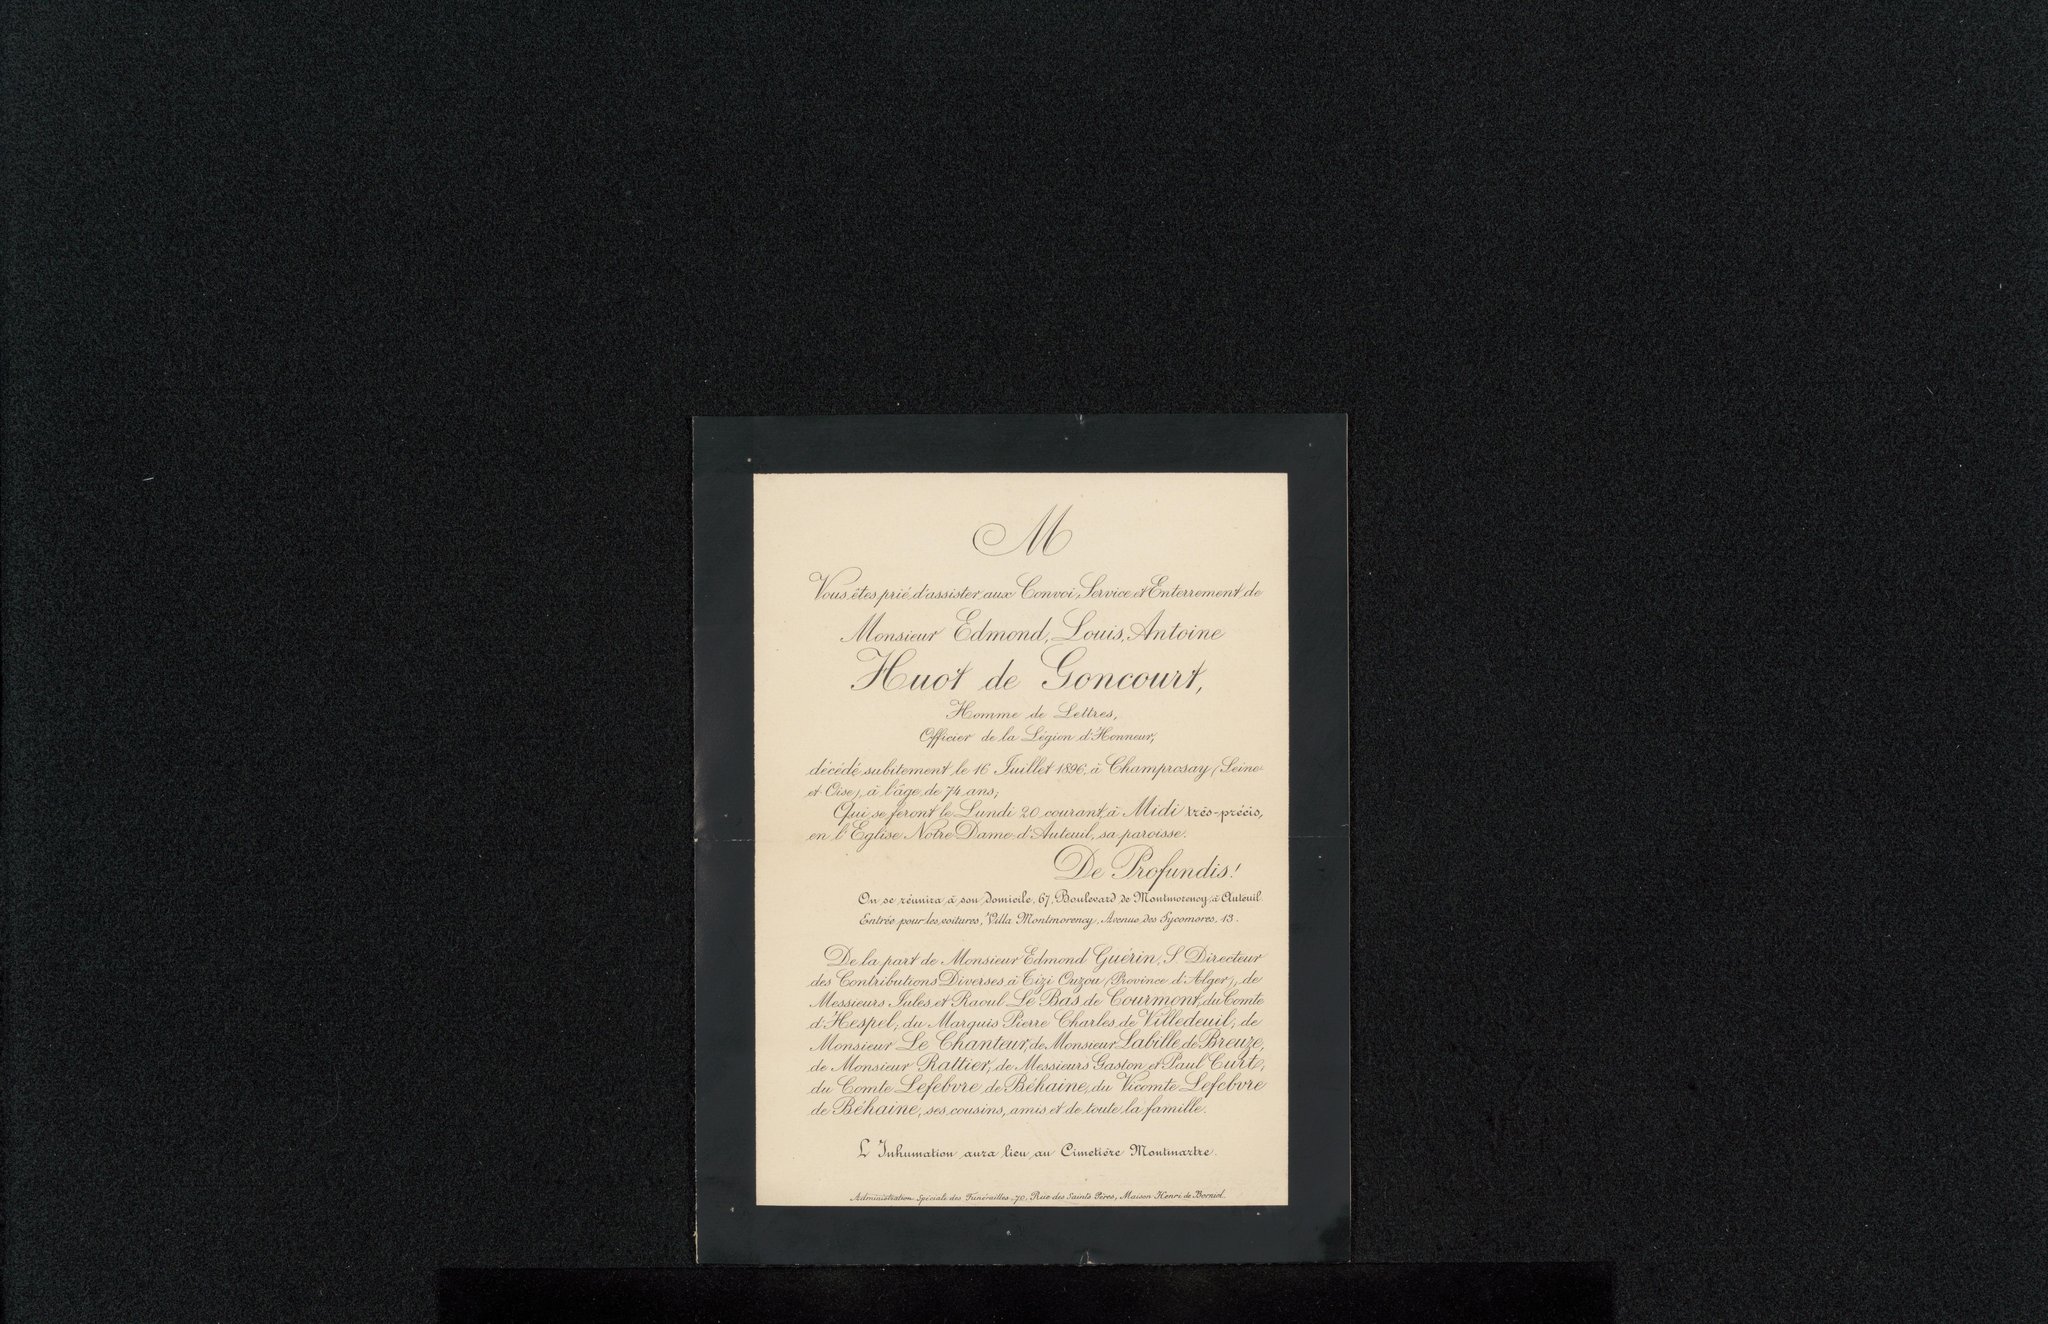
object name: overlijdensbericht, overlijdensadvertentie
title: Overlijdensbericht aan Philip Zilcken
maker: Anonymous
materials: paper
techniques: printing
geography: auteuil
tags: edmond de goncourt, the hague, painter, draughtsman, philip zilcken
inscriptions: collector's mark: ‘RPK’